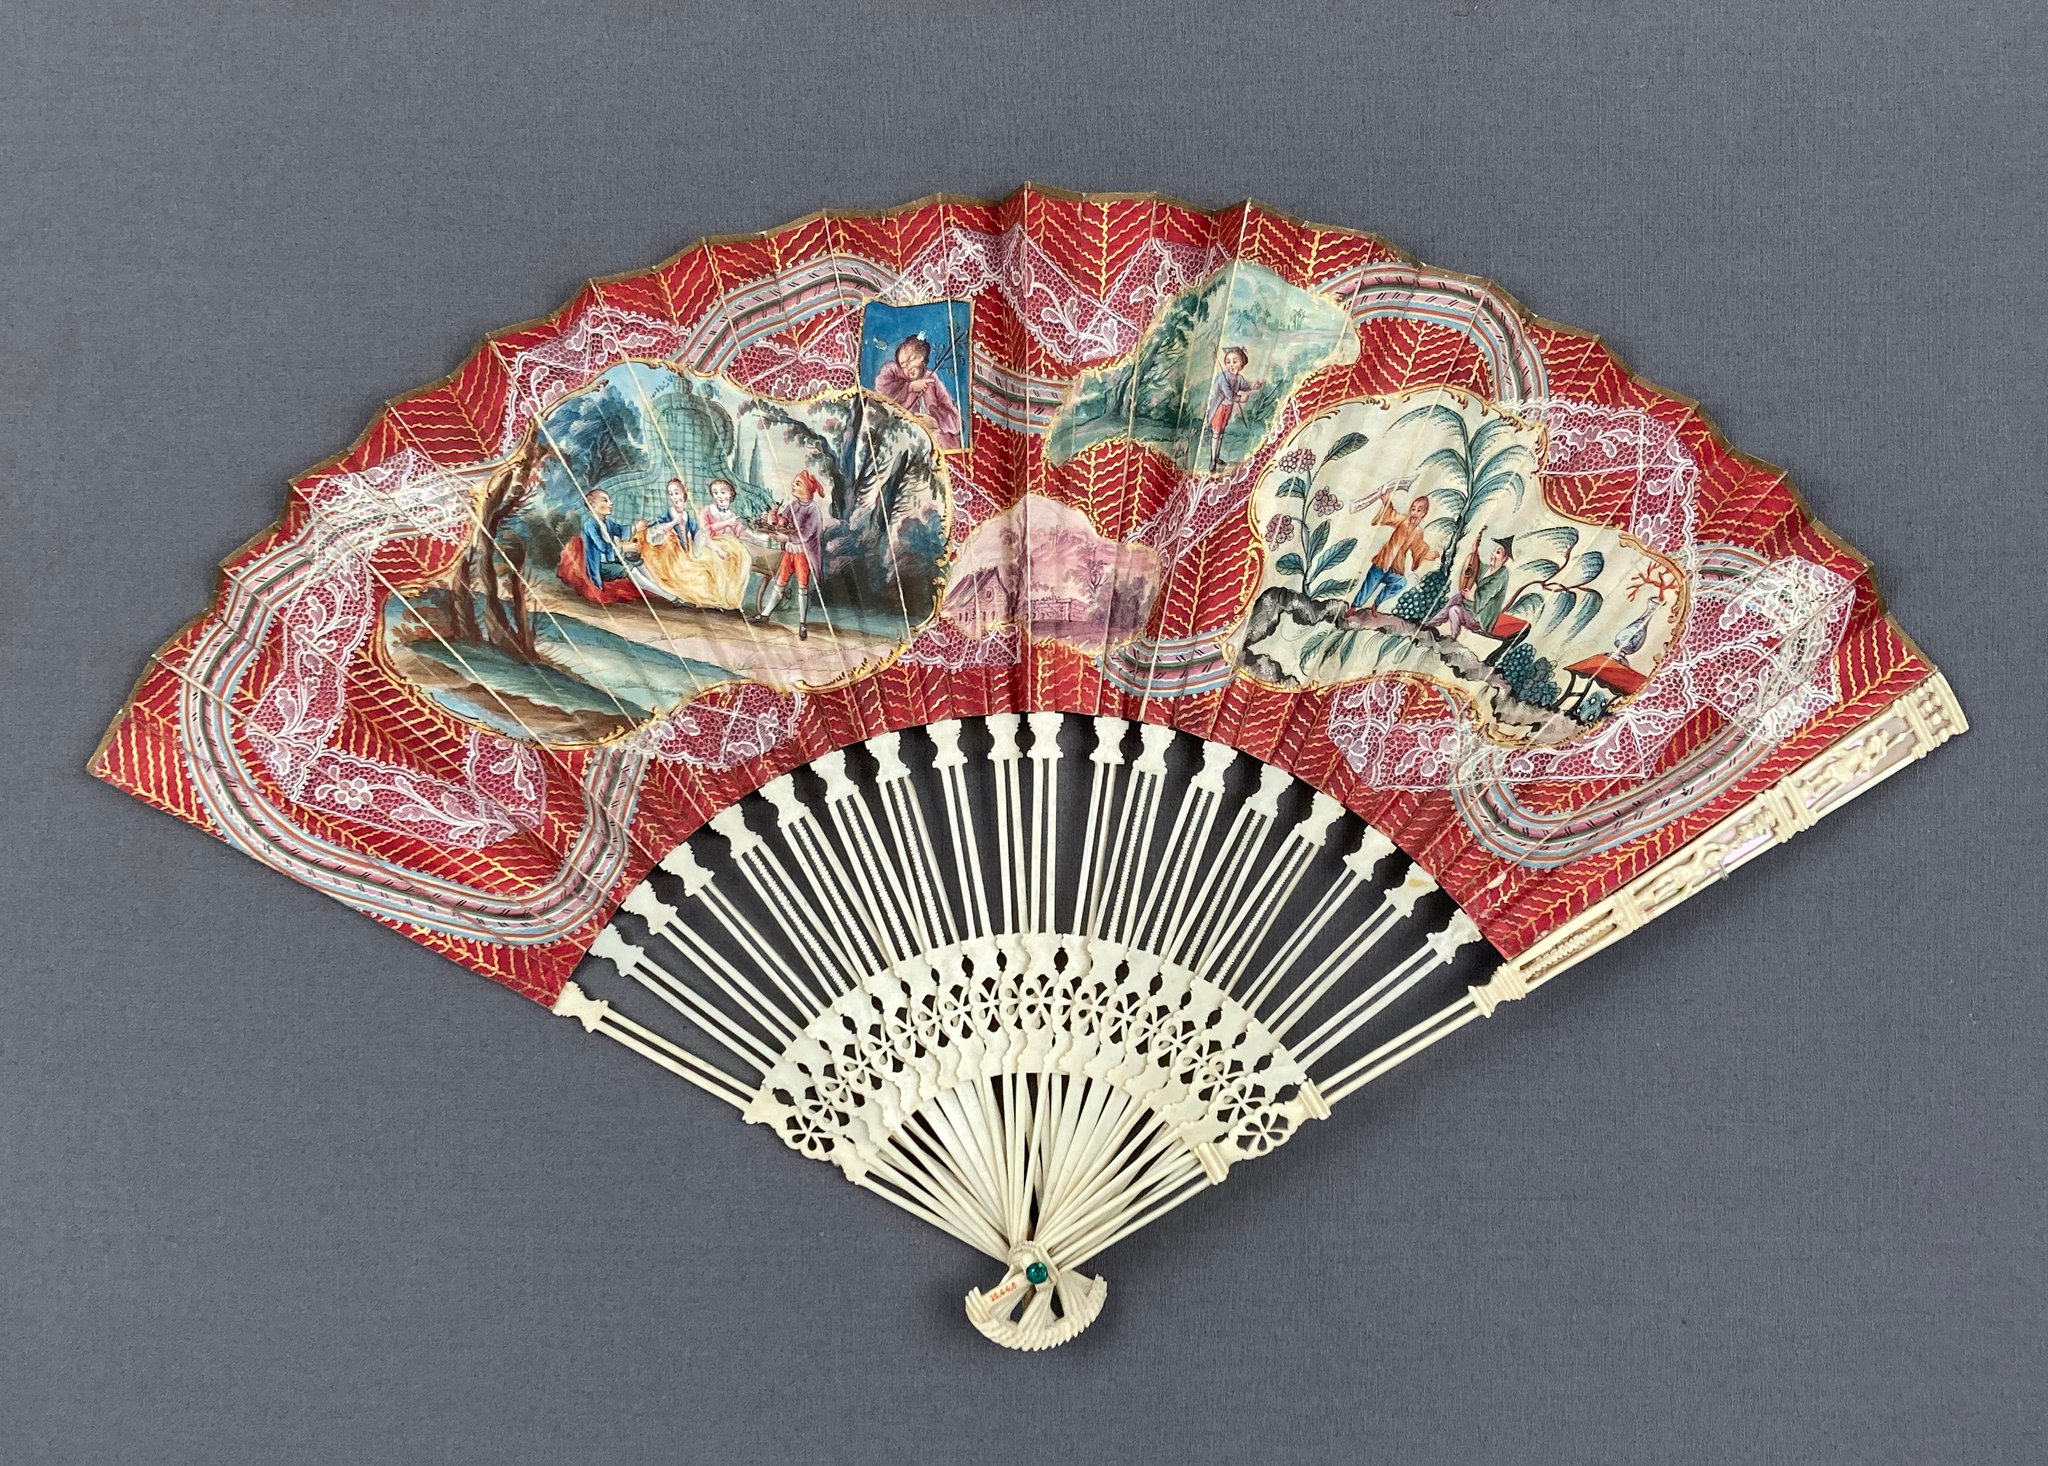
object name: fan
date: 1751-1775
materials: ivory, paper